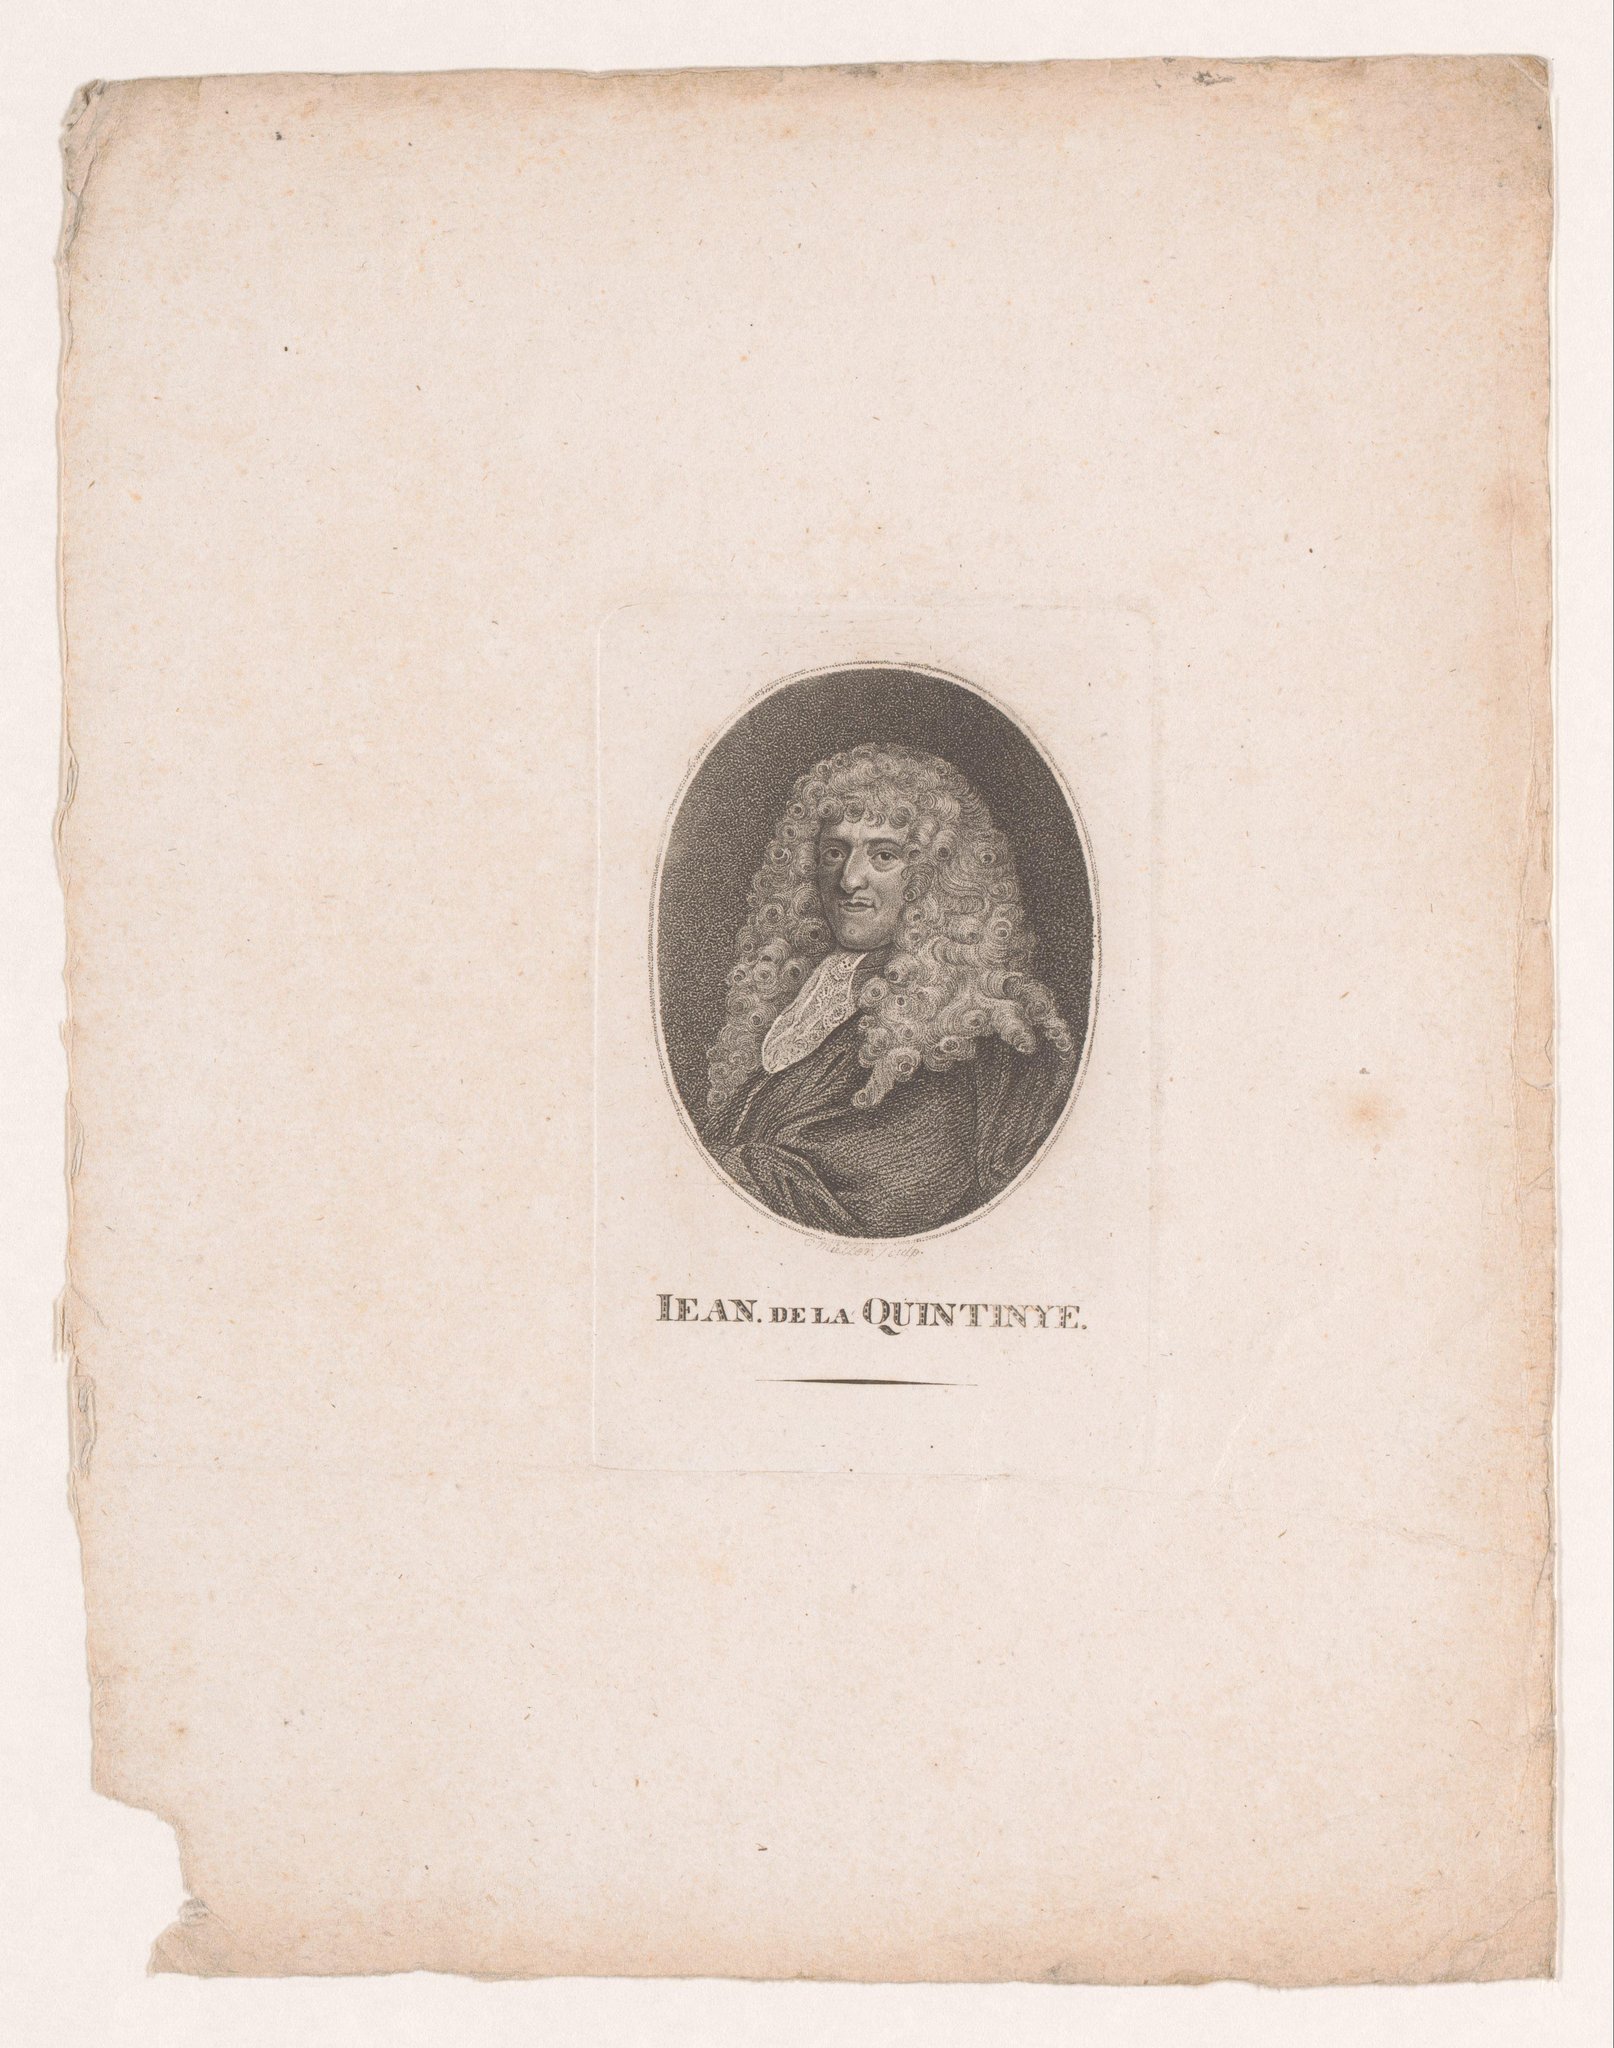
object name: print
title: Portret van Jean-Baptiste de la Quintinie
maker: johann christian ernst müller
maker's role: draughtsman, print maker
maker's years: 1766-1824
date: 1776-1824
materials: paper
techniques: engraving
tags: historical persons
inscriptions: collector's mark: Lugt 2228